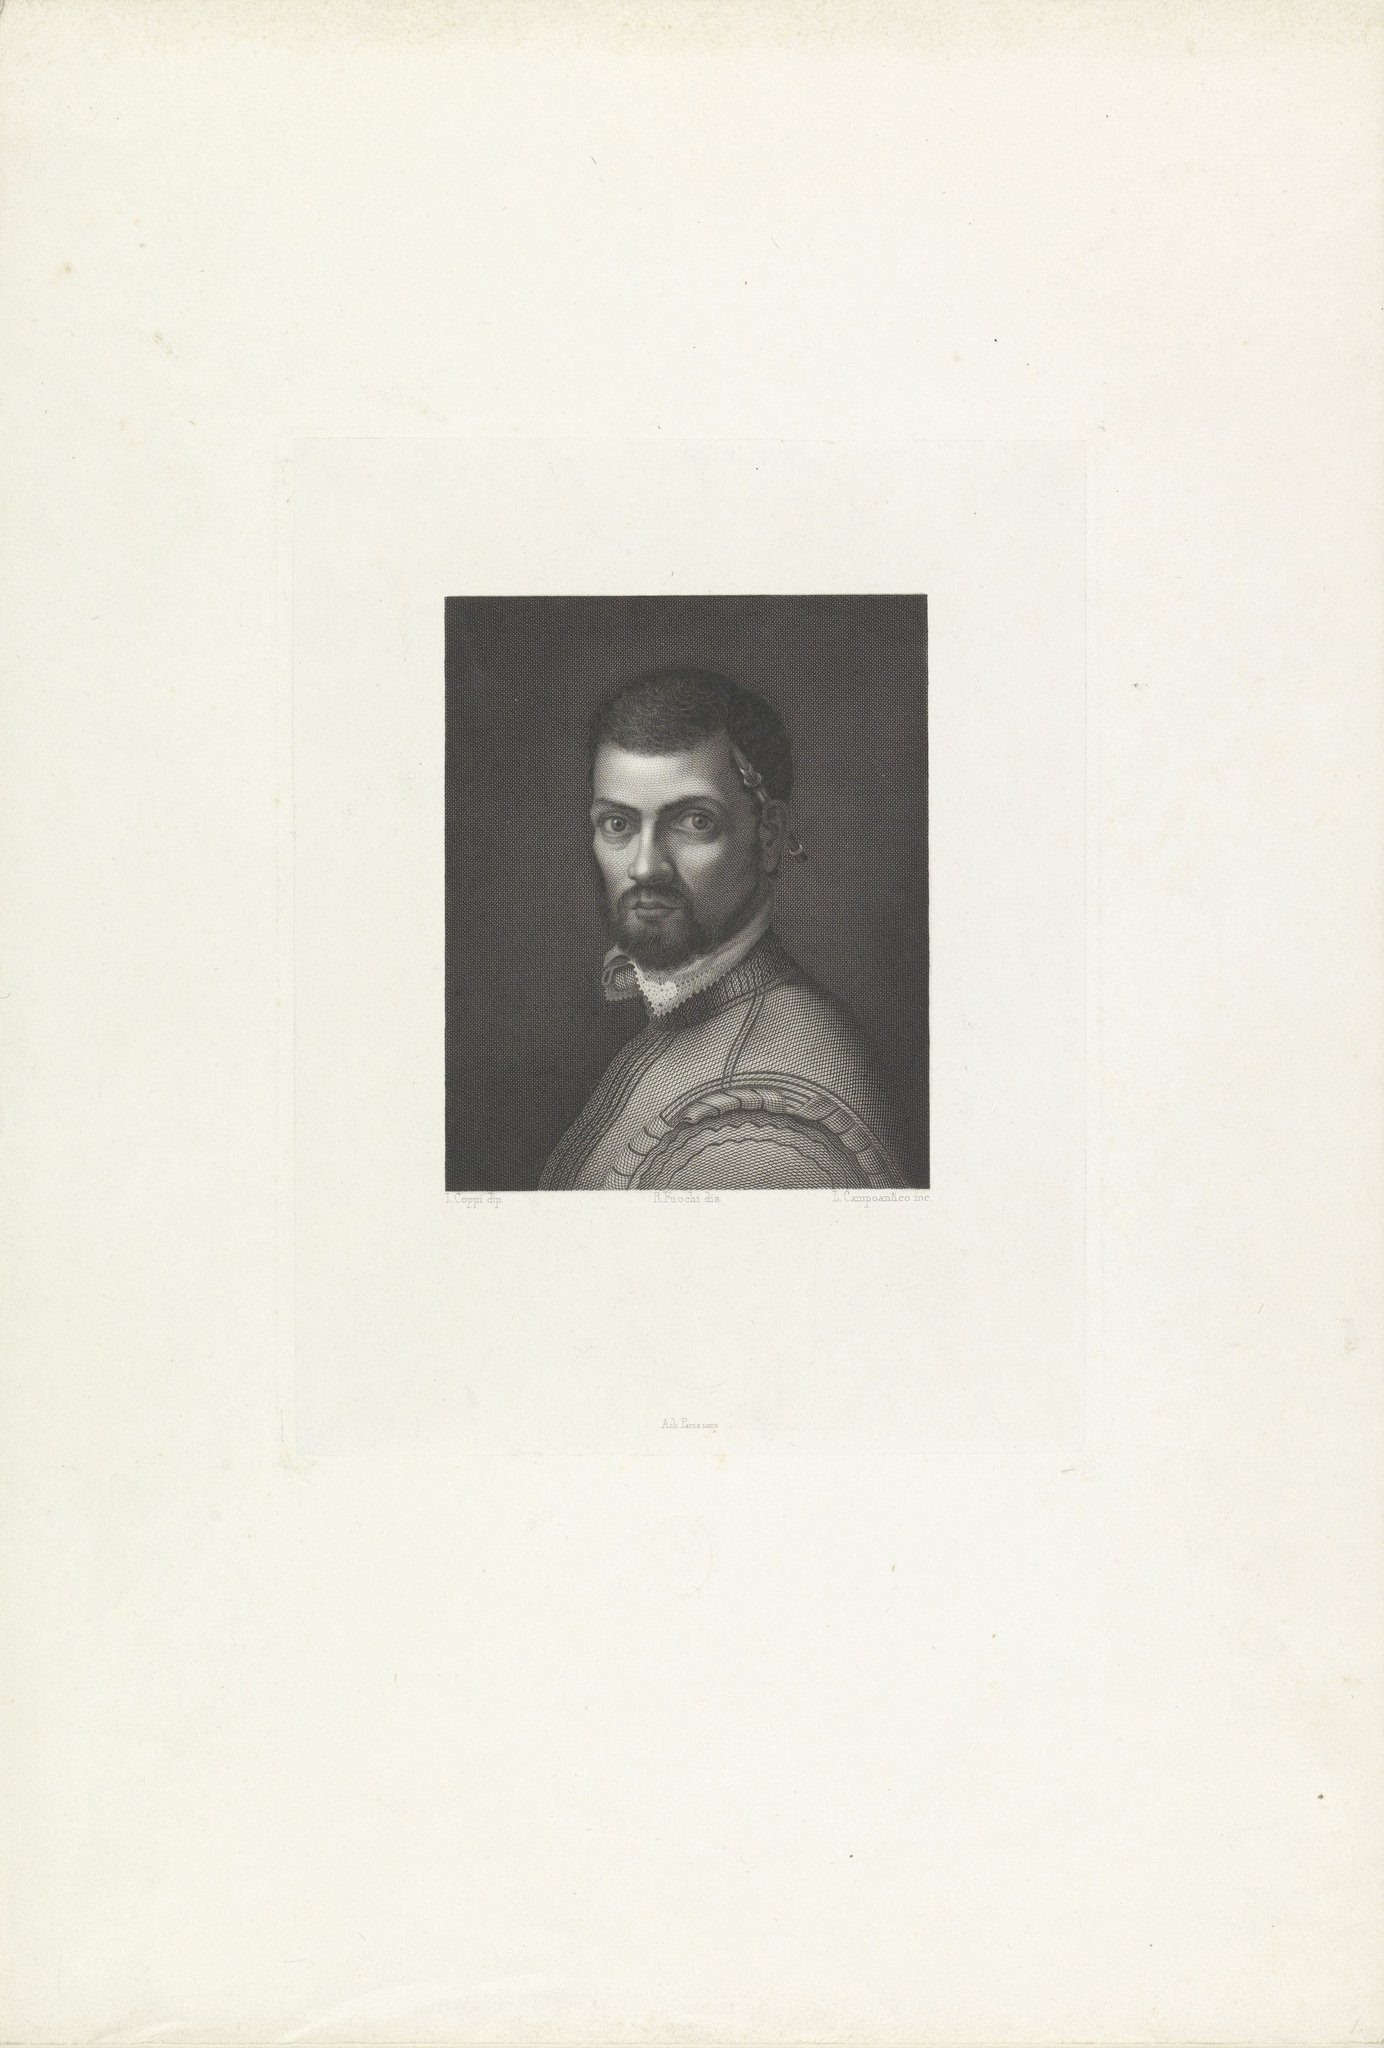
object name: print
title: Portret van man met penseel achter oor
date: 1800-1899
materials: paper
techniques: engraving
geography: paris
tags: historical persons, portrait, self-portrait of artist, brushes ~ implements of painter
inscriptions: collector's mark